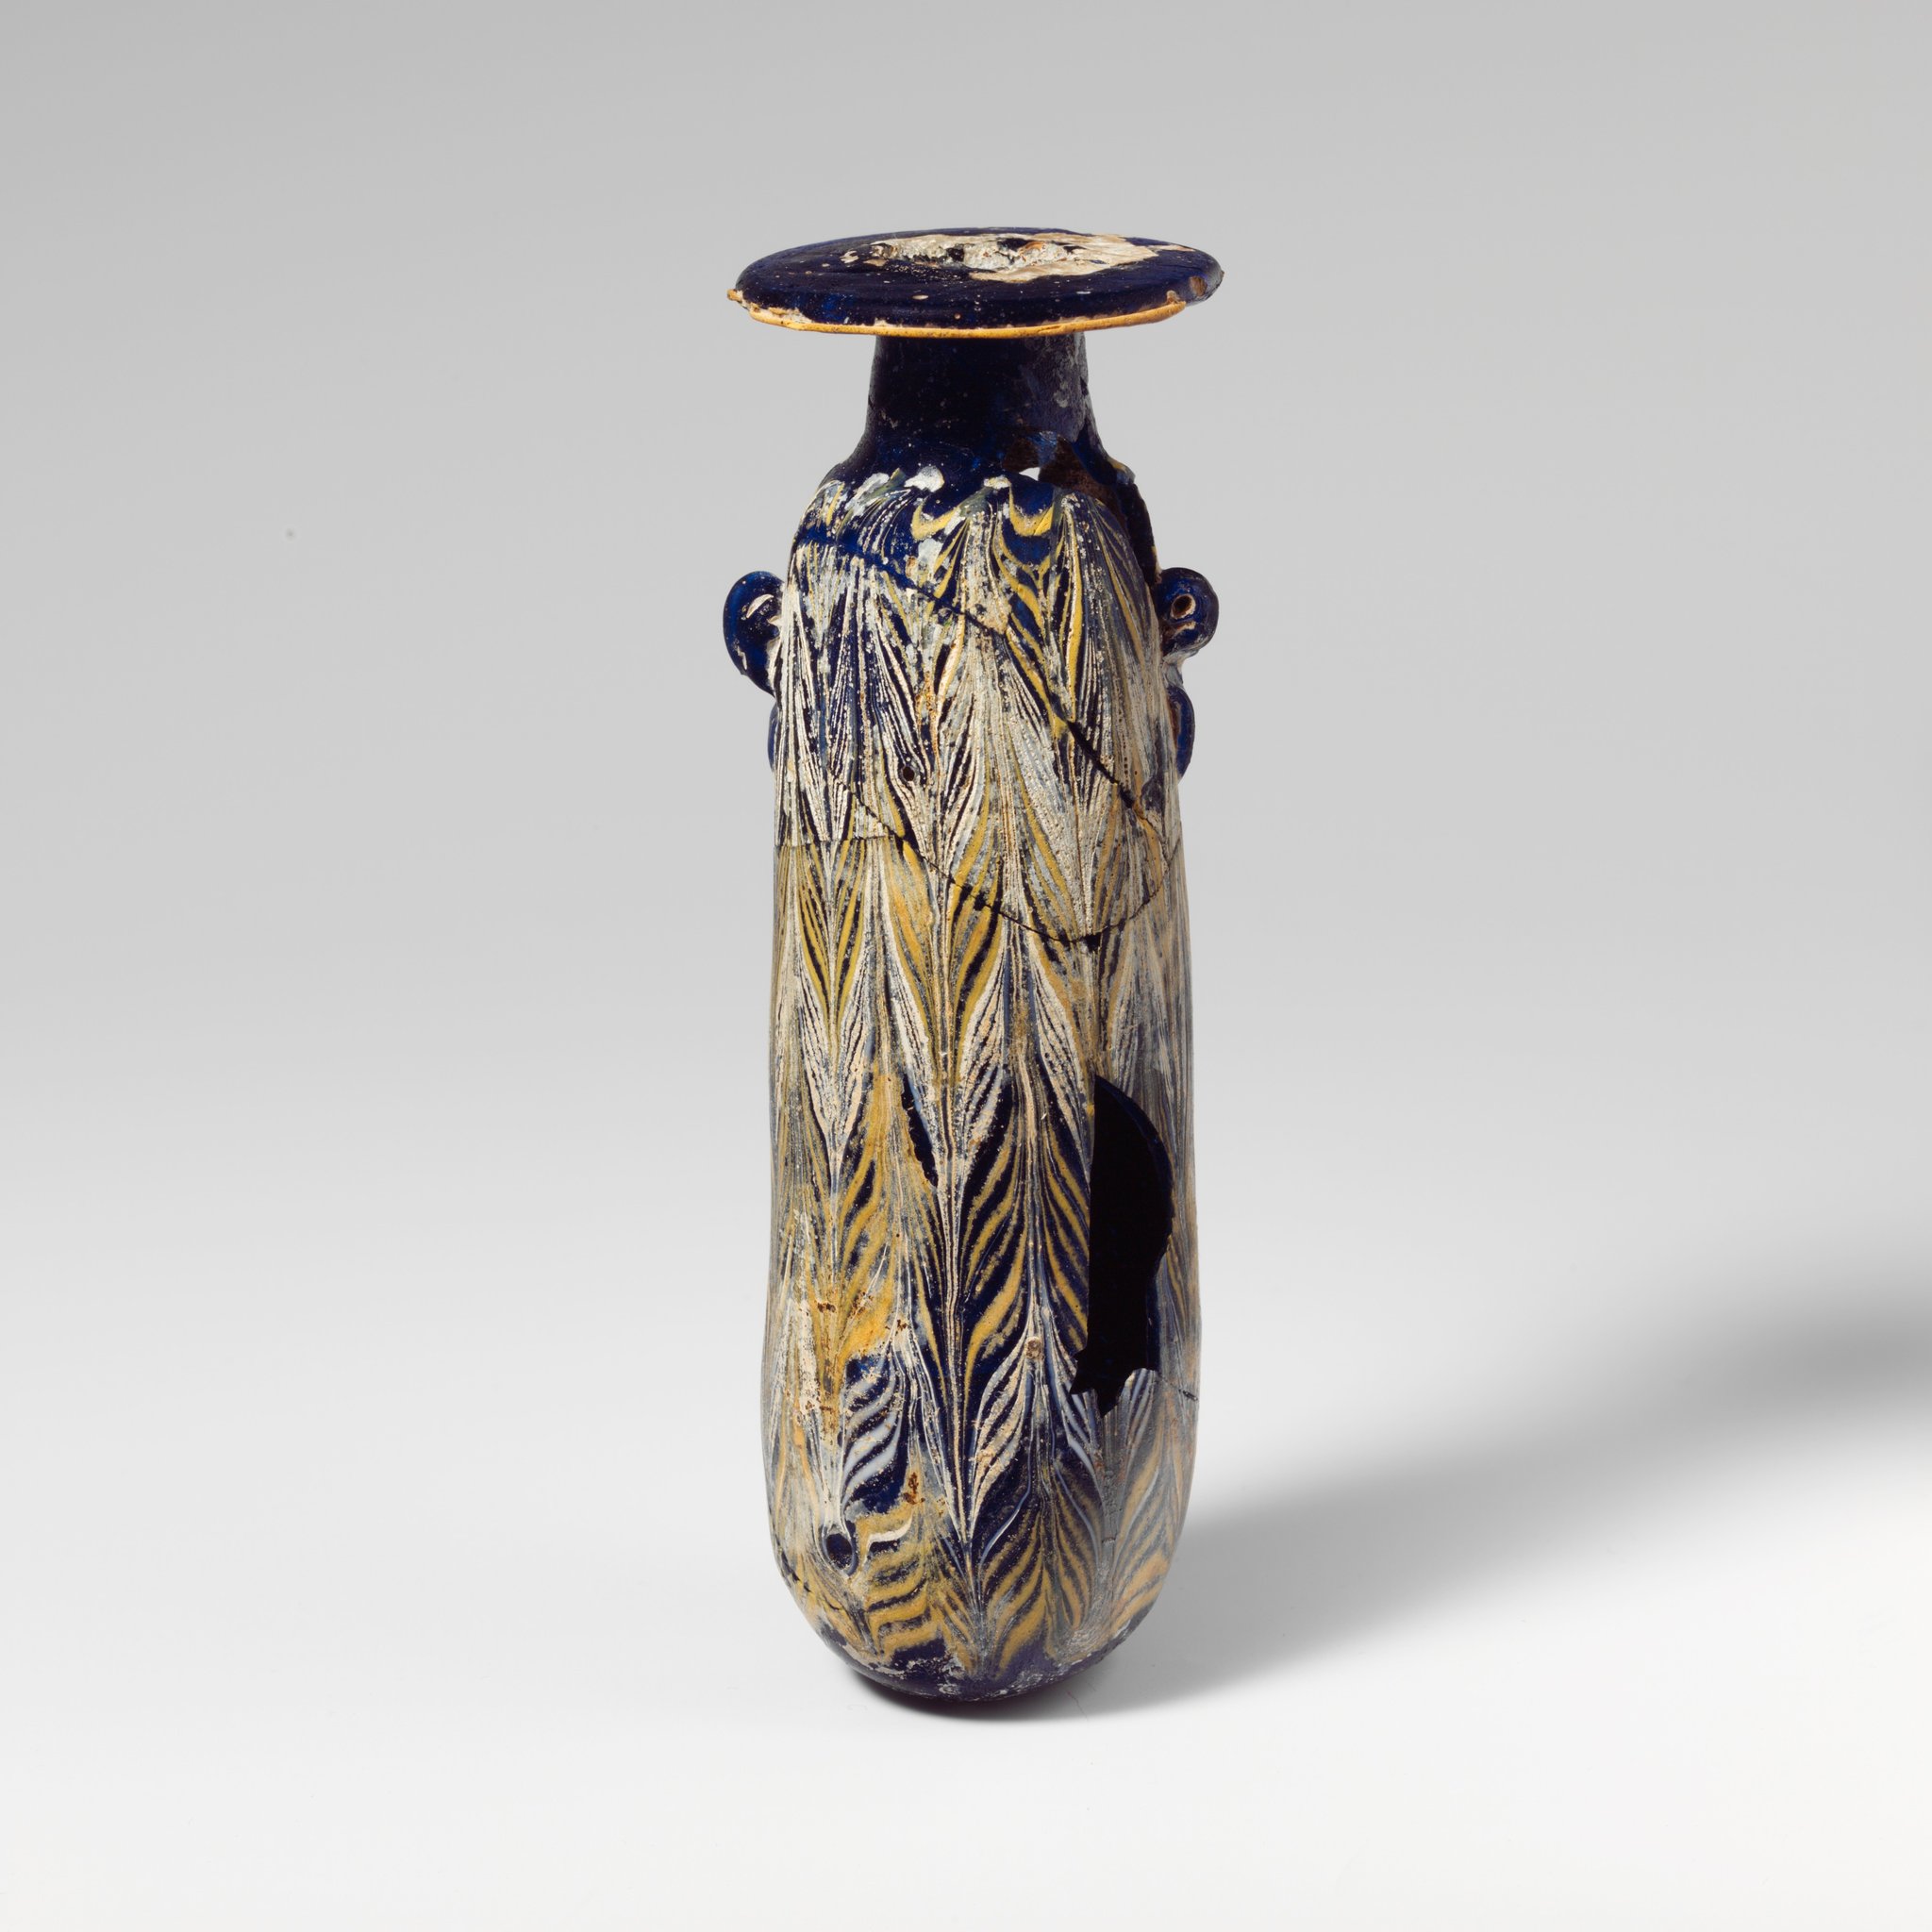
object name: alabastron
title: Glass alabastron (perfume bottle)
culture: greek or eastern mediterranean or italian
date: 367-268 BCE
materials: glass